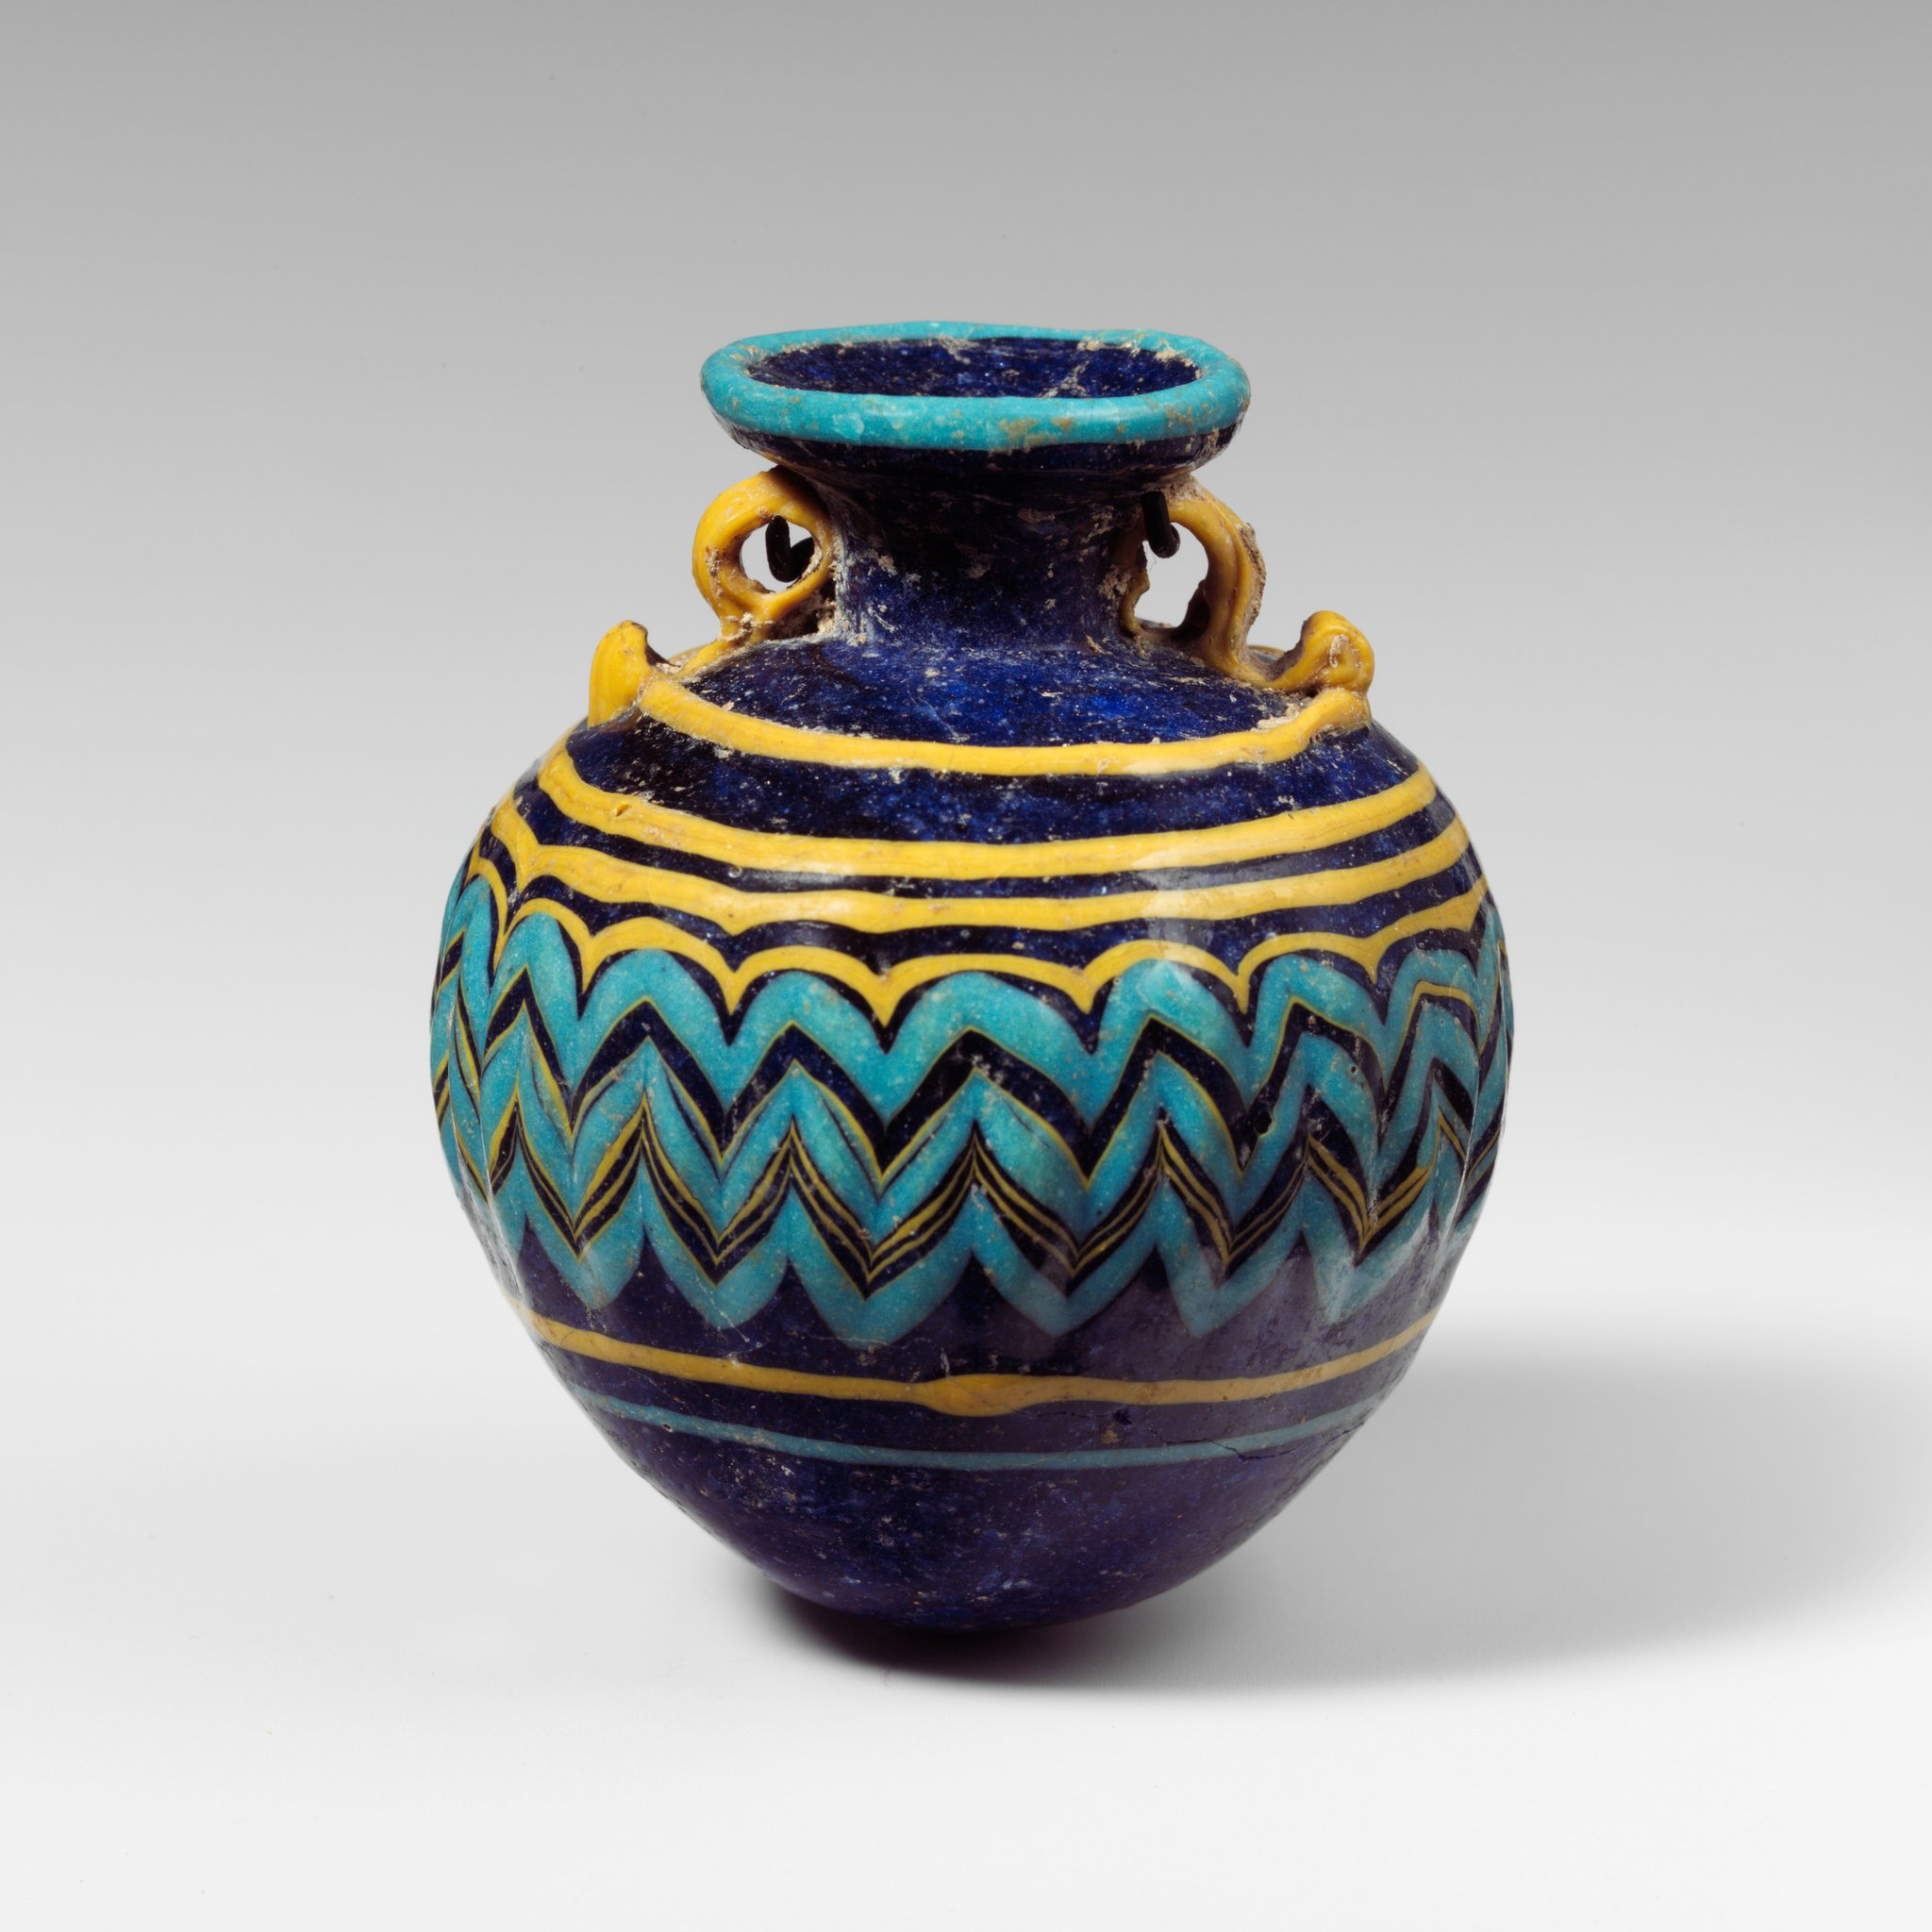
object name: aryballos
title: Glass aryballos (perfume bottle)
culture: greek, eastern mediterranean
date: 534-401 BCE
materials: glass